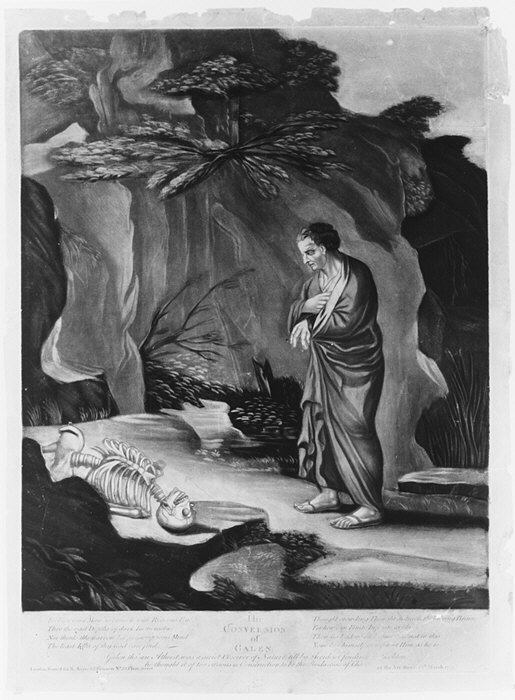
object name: print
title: The Conversion of Galen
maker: robert sayer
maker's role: publisher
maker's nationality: british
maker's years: 1725-1794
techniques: hand coloring, mezzotint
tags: skeletons,men